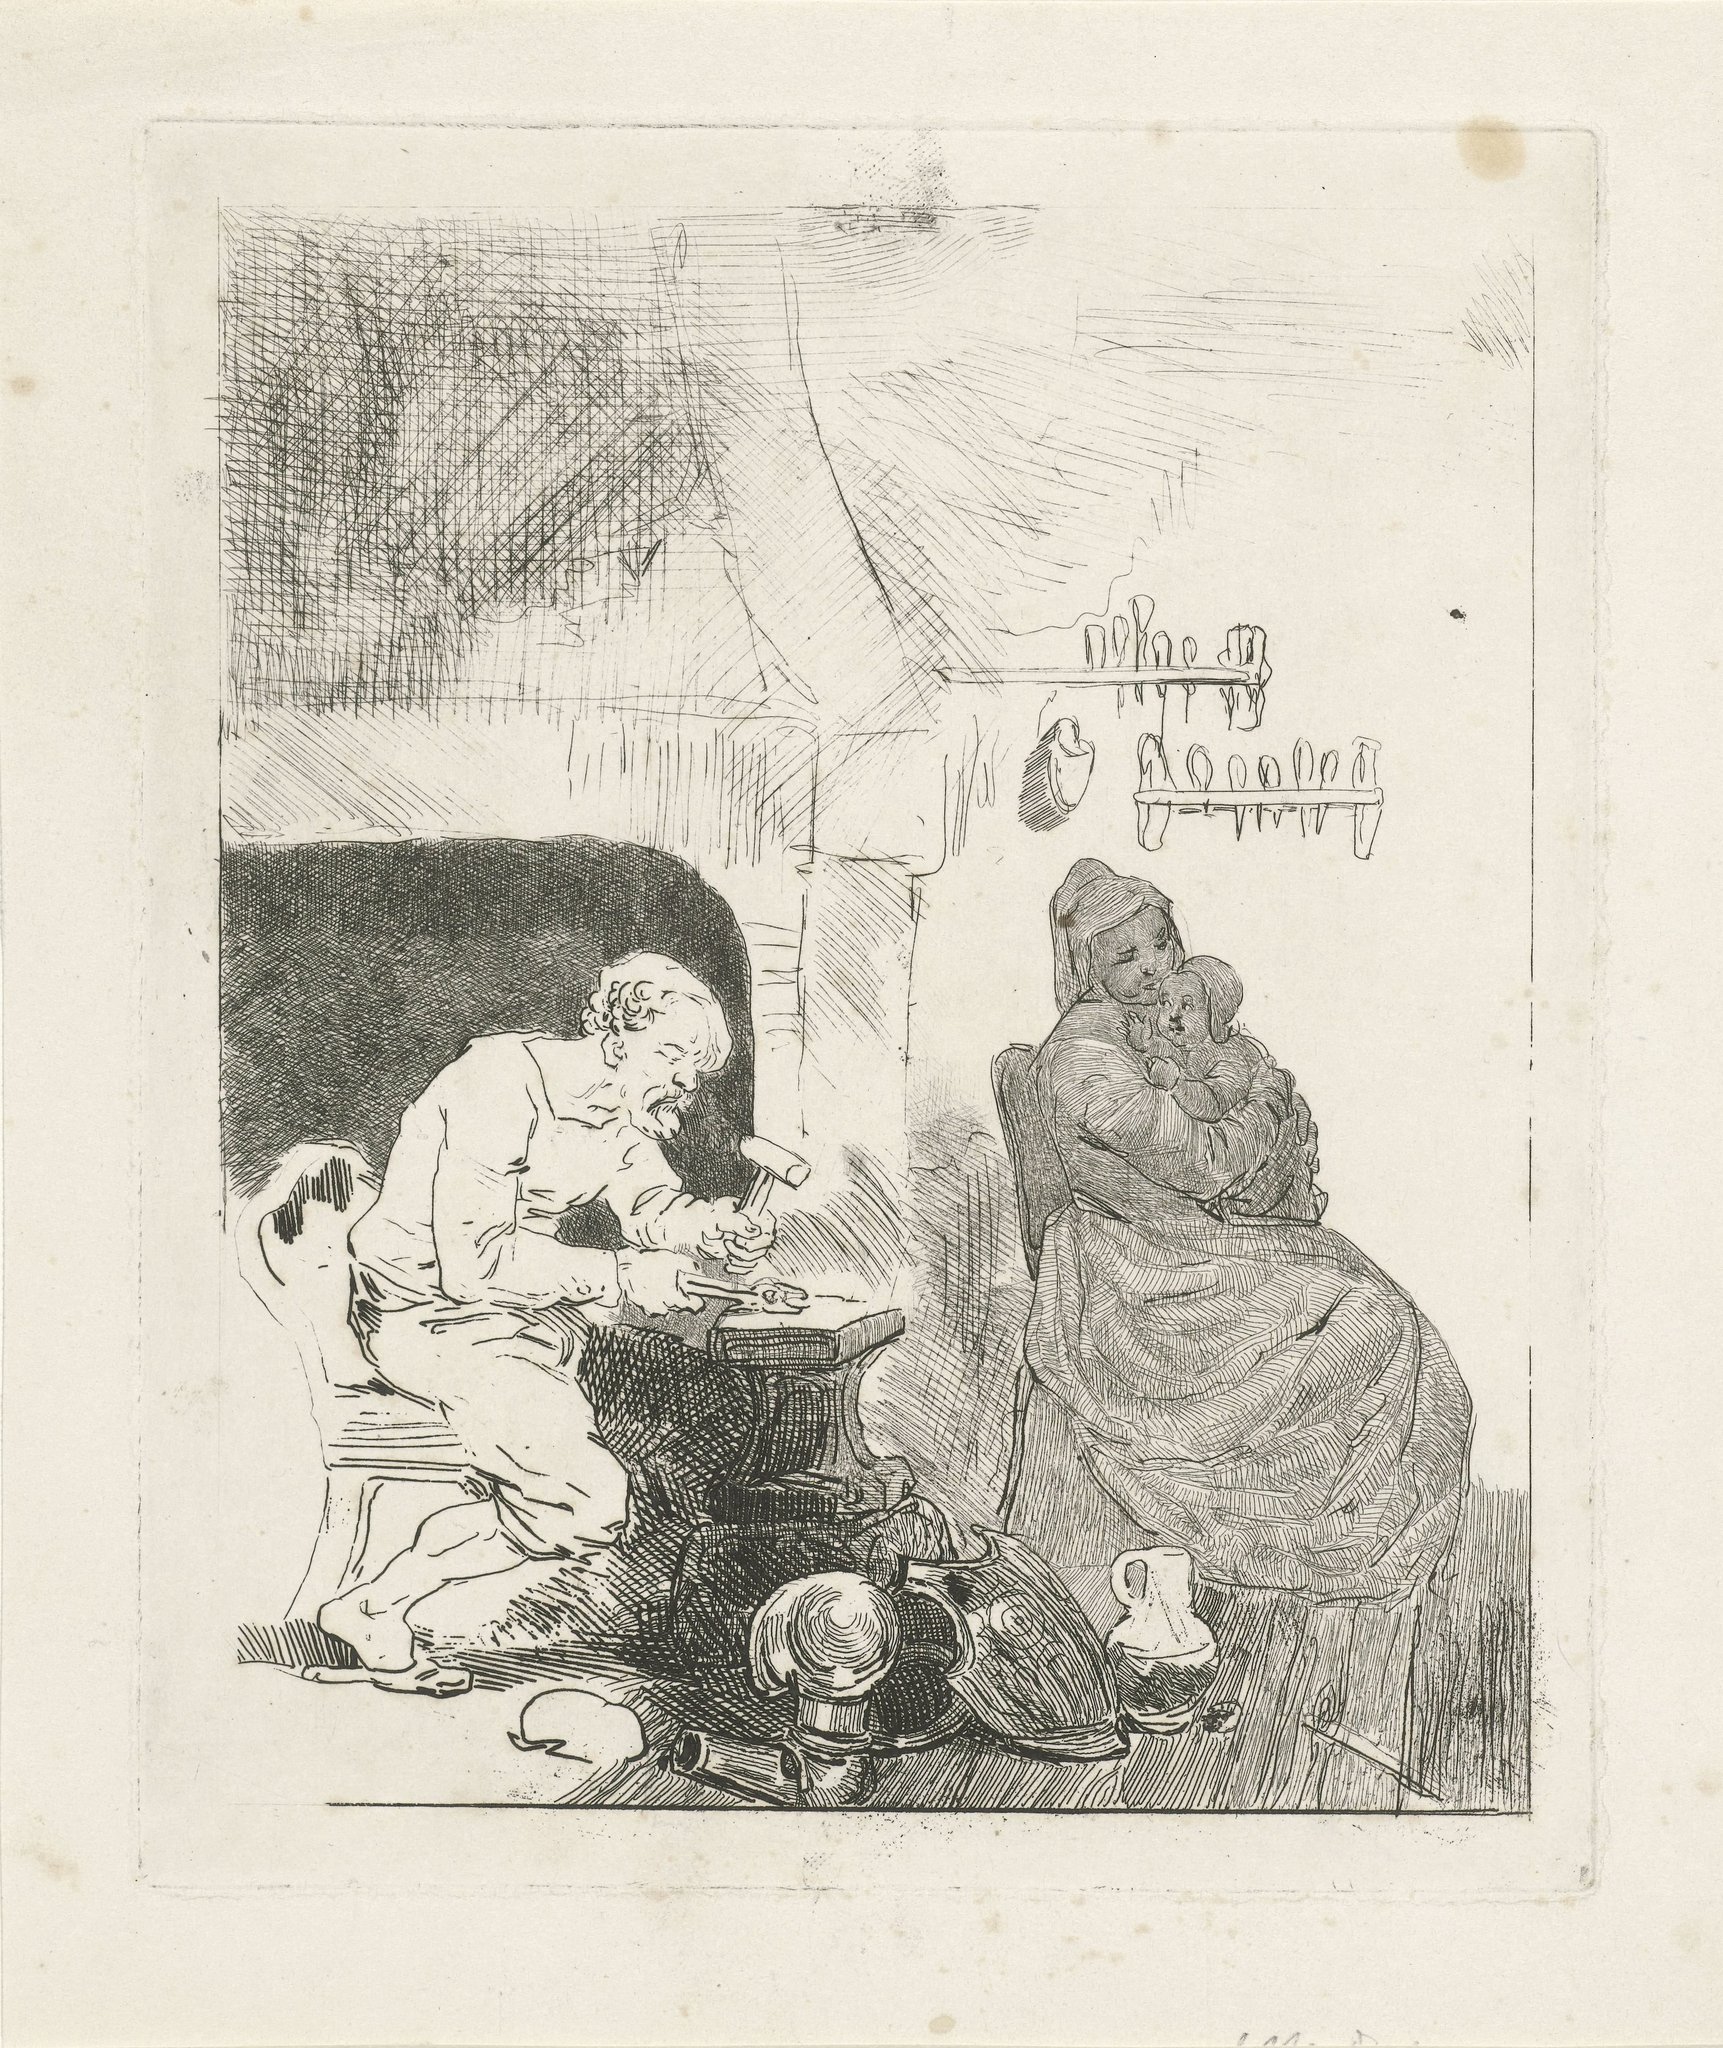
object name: print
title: Wapensmid aan het werk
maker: reinier craeyvanger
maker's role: draughtsman, print maker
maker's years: 1812-1880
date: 1822-1880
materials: paper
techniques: etching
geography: amsterdam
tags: smith, blacksmith (+ indoors; in laboratory, factory, barn, etc.), armour, mother and baby or young child, handicrafts ~ metal, forging (industrial process)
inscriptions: collector's mark: Lugt 2228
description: Een wapensmid zit op een stoel voor een aambeeld en bewerkt met een hamer een voorwerp dat hij in een tang vasthoudt. Naast het aambeeld liggen delen van een harnas. Achter hem een haard. Rechts zit zijn vrouw met een kind in de armen.